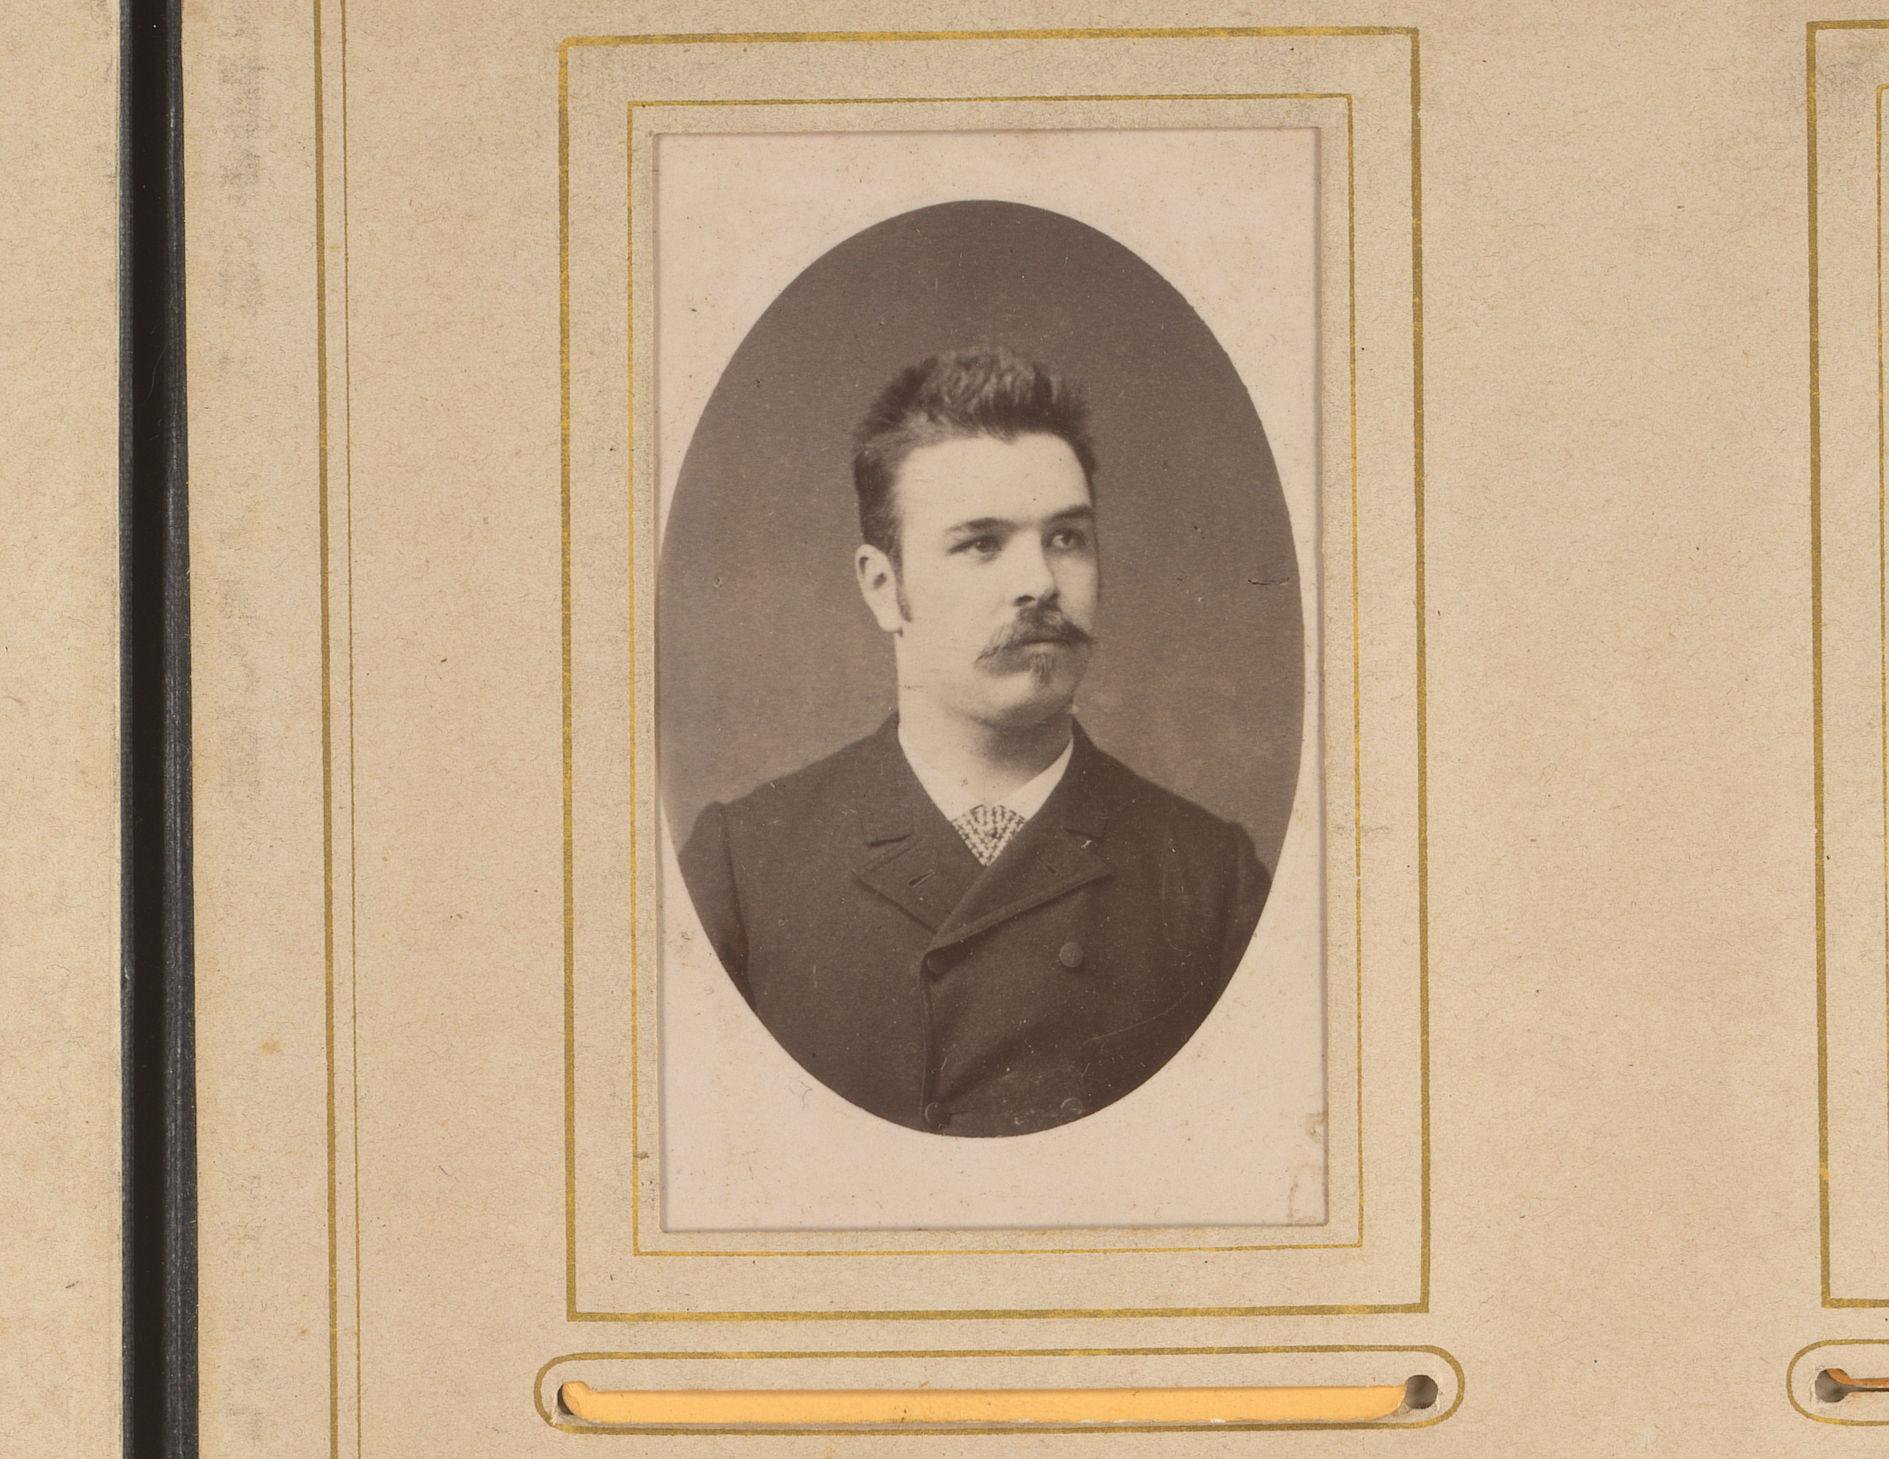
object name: photograph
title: Portret van een man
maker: marie séraphine gonthier-cornand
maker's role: fotograaf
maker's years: 1843-1889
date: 1881-1893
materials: cardboard, photographic support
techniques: albumen print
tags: adult man, historical persons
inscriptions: inscription: ‘Madame Gonthier-Cornand/ Photographies/ 12 Boulevard d'Avroy 12/ Liege/ 14 Rue de Flandre 14 Gand/ Maison Maestricht (Hollande)’, name: ‘Gonthier-Cornand Liege’